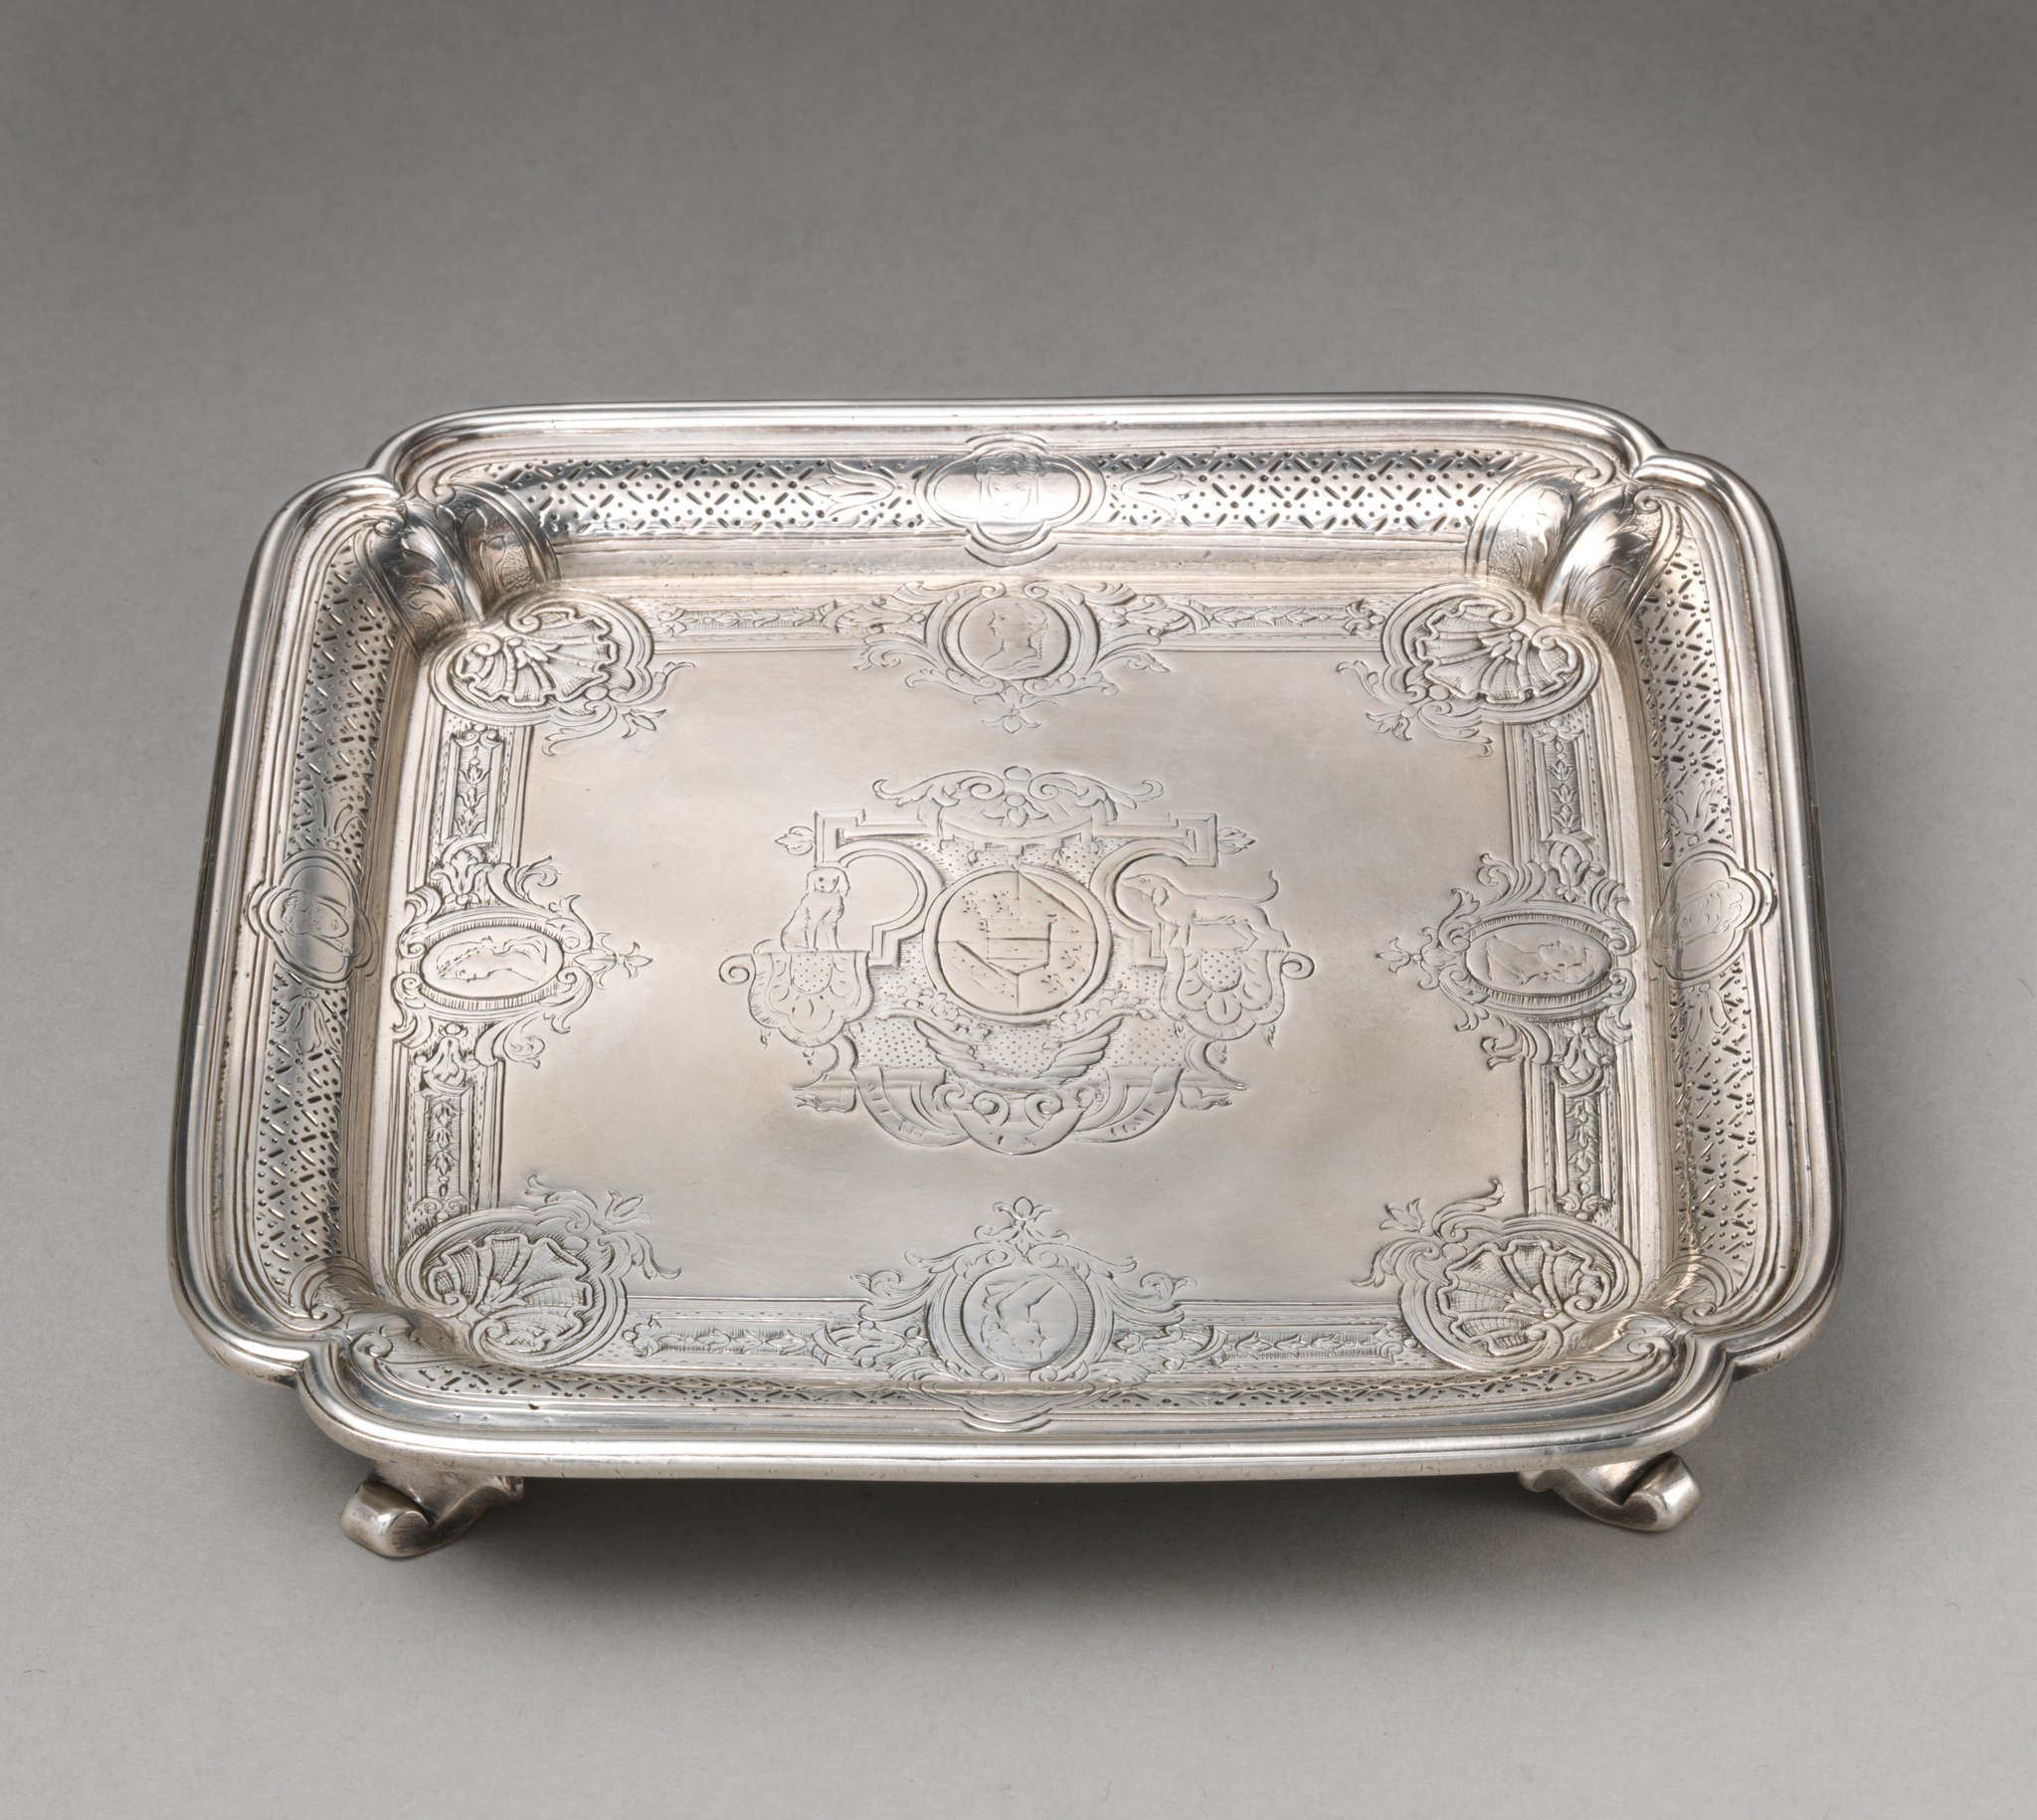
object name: salver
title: Salver (one of a pair)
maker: paul de lamerie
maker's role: maker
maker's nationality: british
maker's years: 1688-1751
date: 1731-1732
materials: silver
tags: heads,dogs,flowers,coat of arms